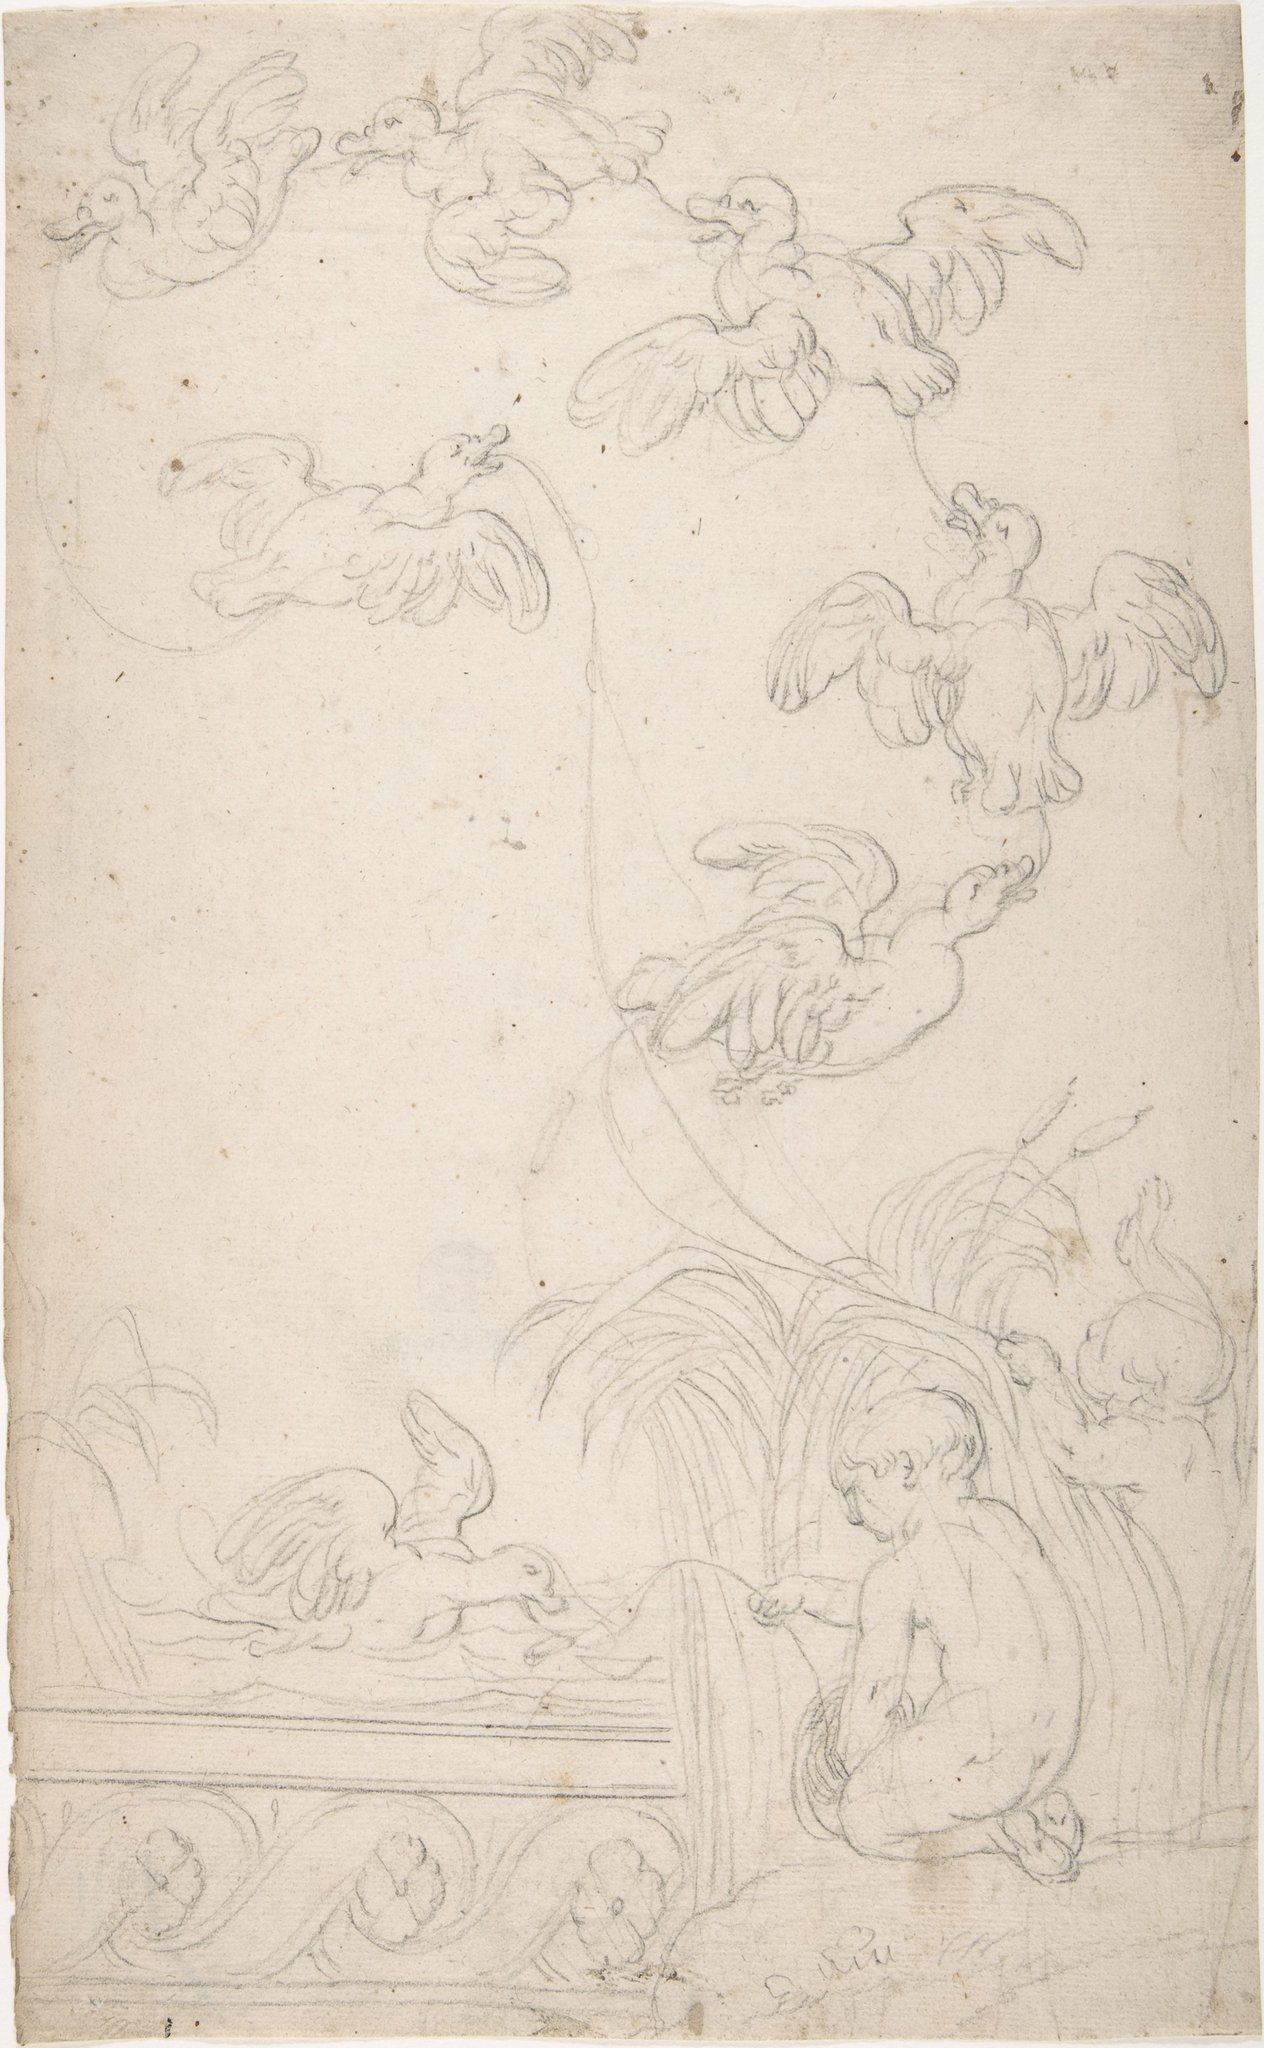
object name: drawing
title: Ornament with Children Catching Ducks on Baited Strings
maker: anonymous, german, 19th century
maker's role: artist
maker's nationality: german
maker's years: 1800-1899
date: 1780-1820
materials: graphite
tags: ducks,children